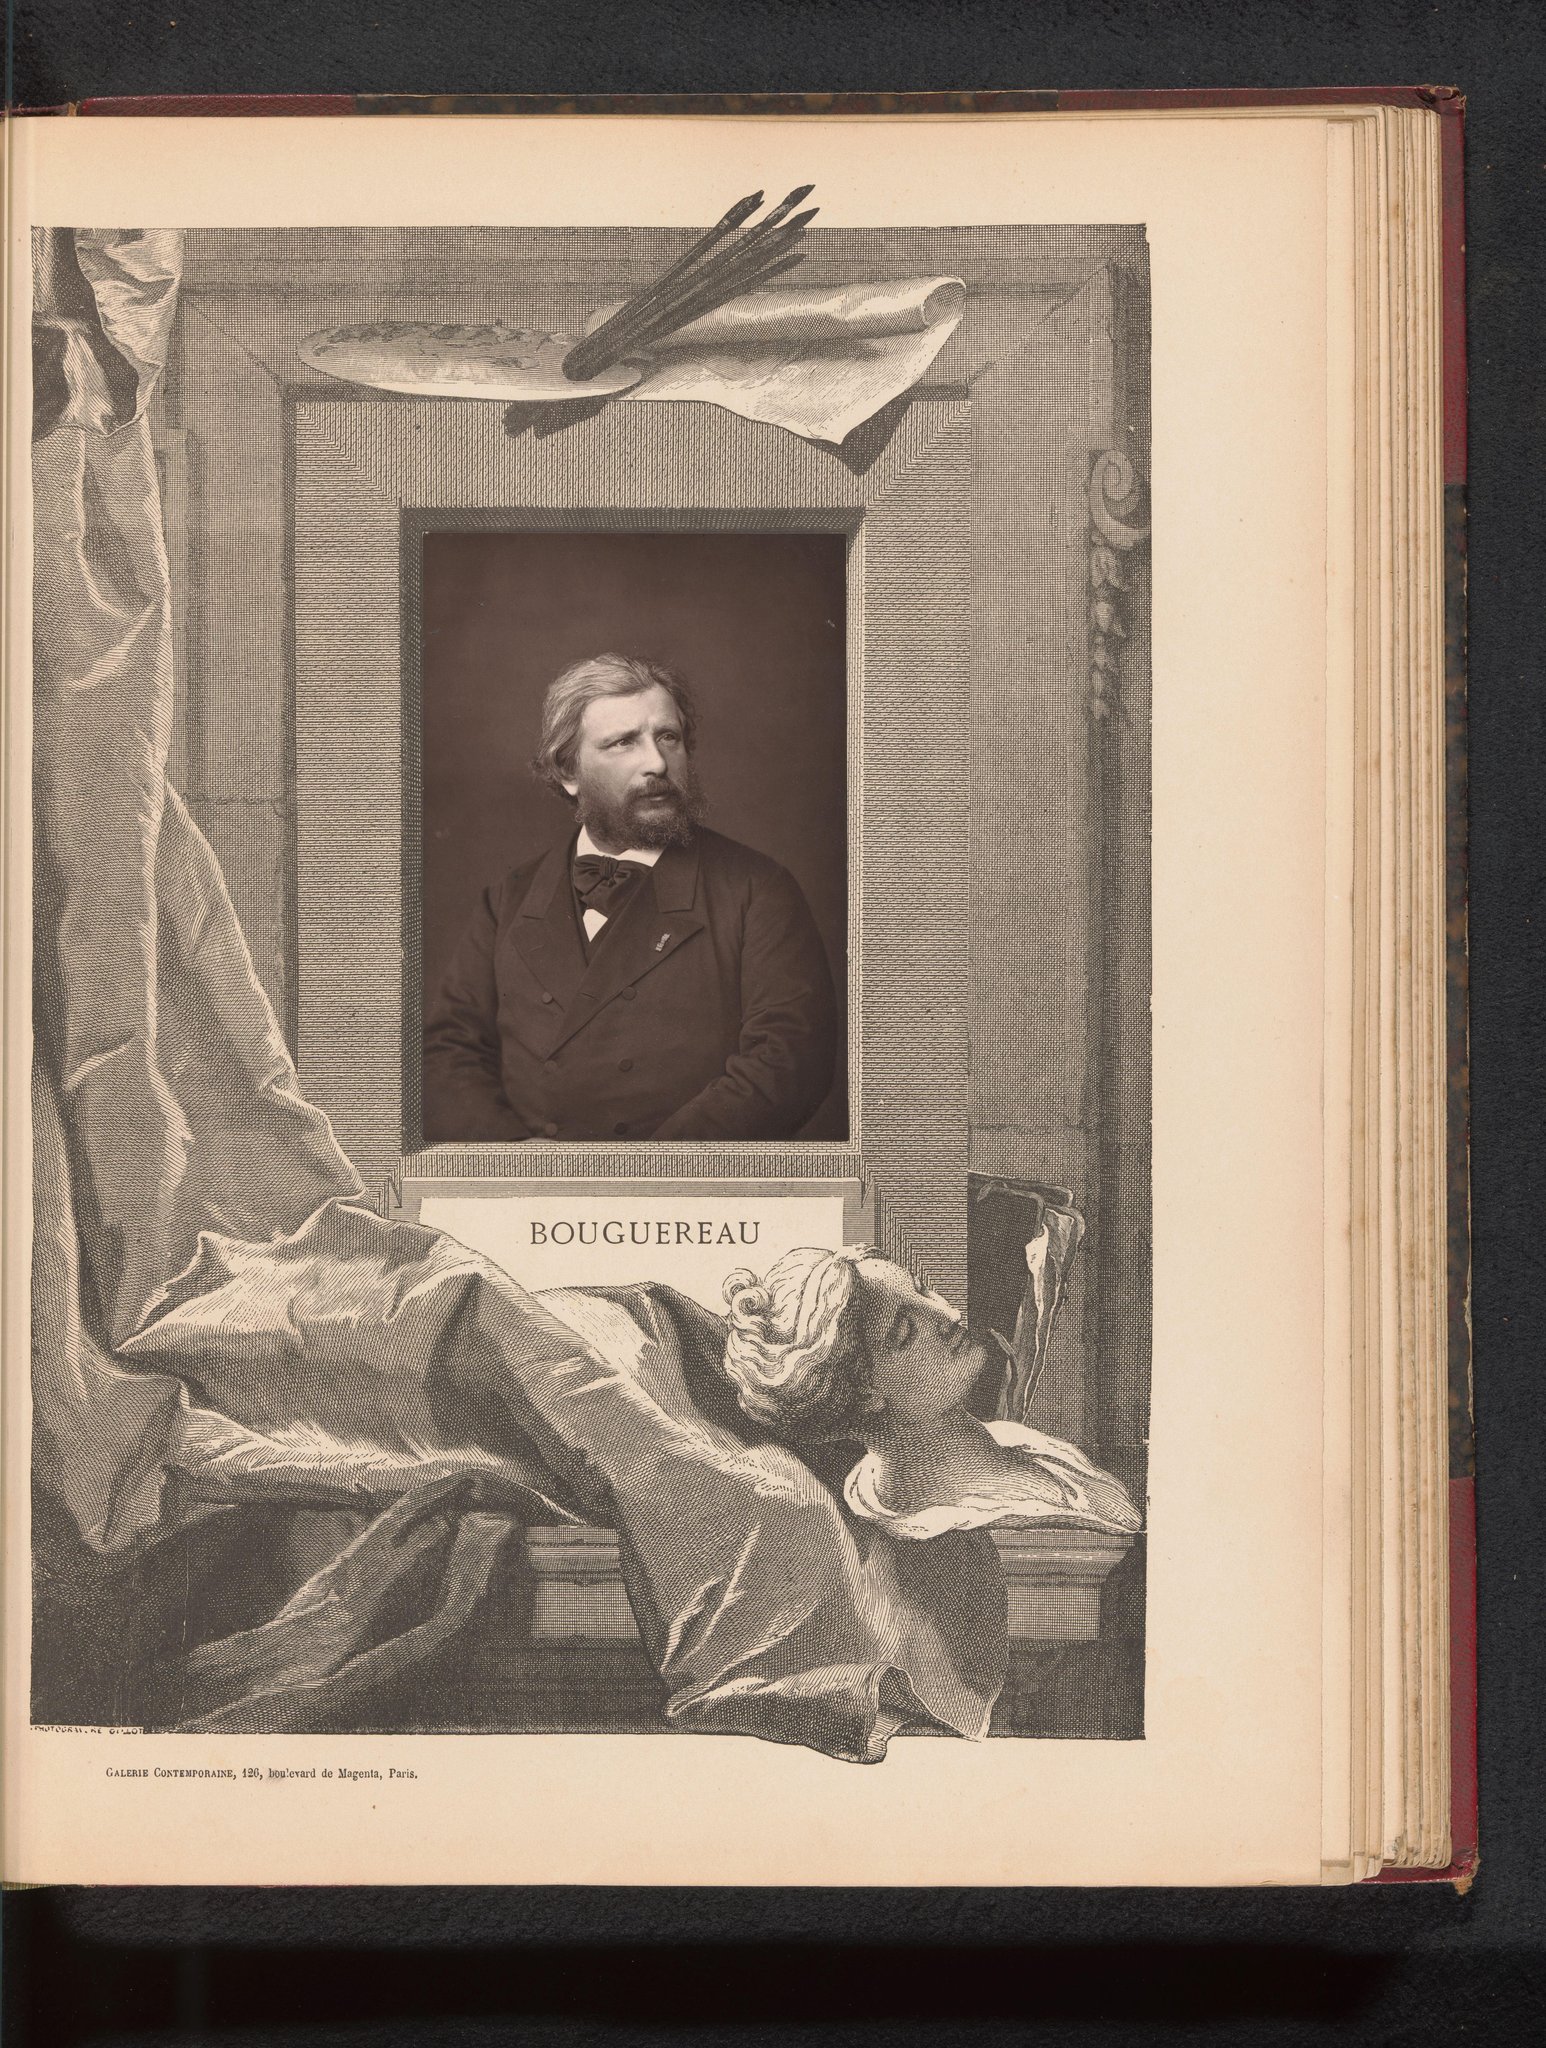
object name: page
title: Portret van William-Adolphe Bouguereau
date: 1871-1876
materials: paper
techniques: printing block, woodburytype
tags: painter, draughtsman, adult man, historical persons